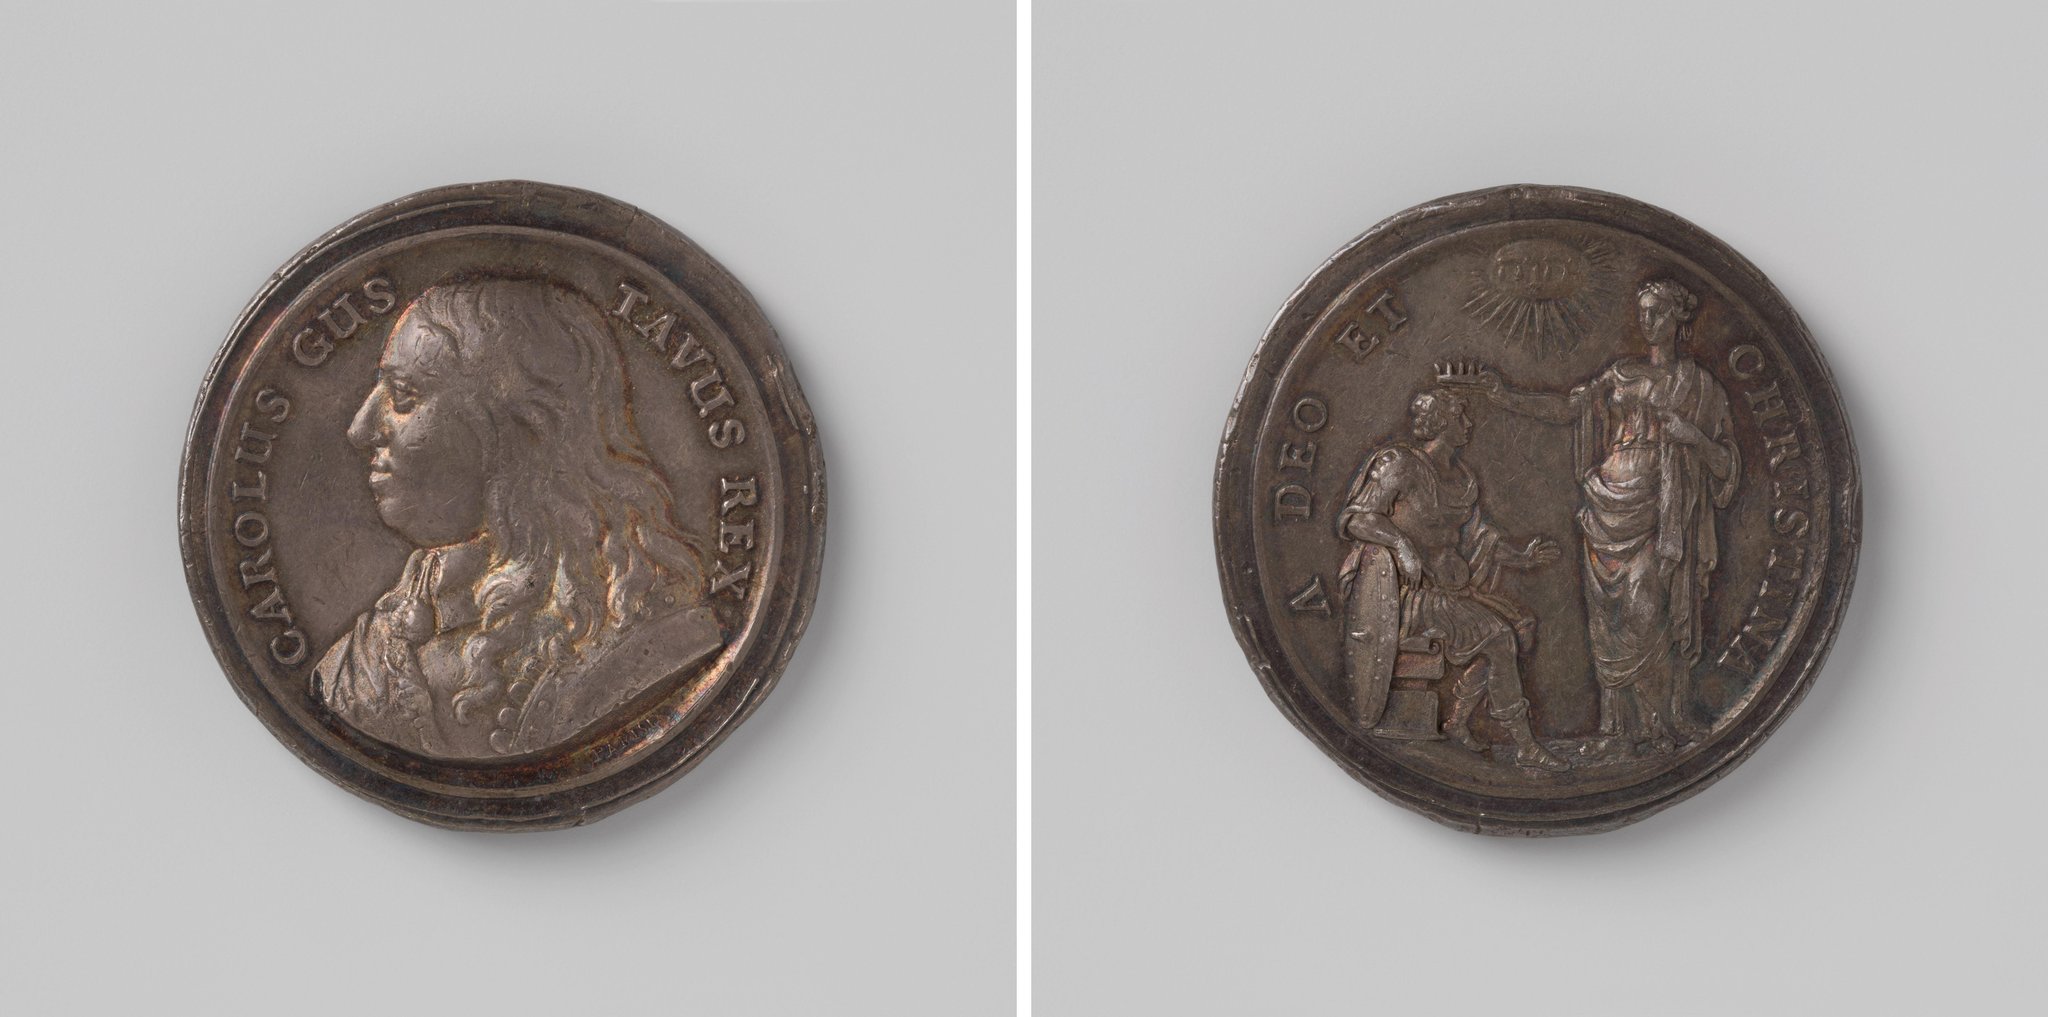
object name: history medal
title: Karel Gustaaf Adolf X, gekroond tot koning van Zweden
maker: jean parise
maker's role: medailleur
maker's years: 1630-1655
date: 1654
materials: silver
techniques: striking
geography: stockholm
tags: nyköping, koning, karel x gustaaf (koning van zweden)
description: Zilveren penning. Voorzijde: borststuk man binnen omschrift. Keerzijde: staande vrouw zet kroon op hoofd van zittende man binnen omschrift